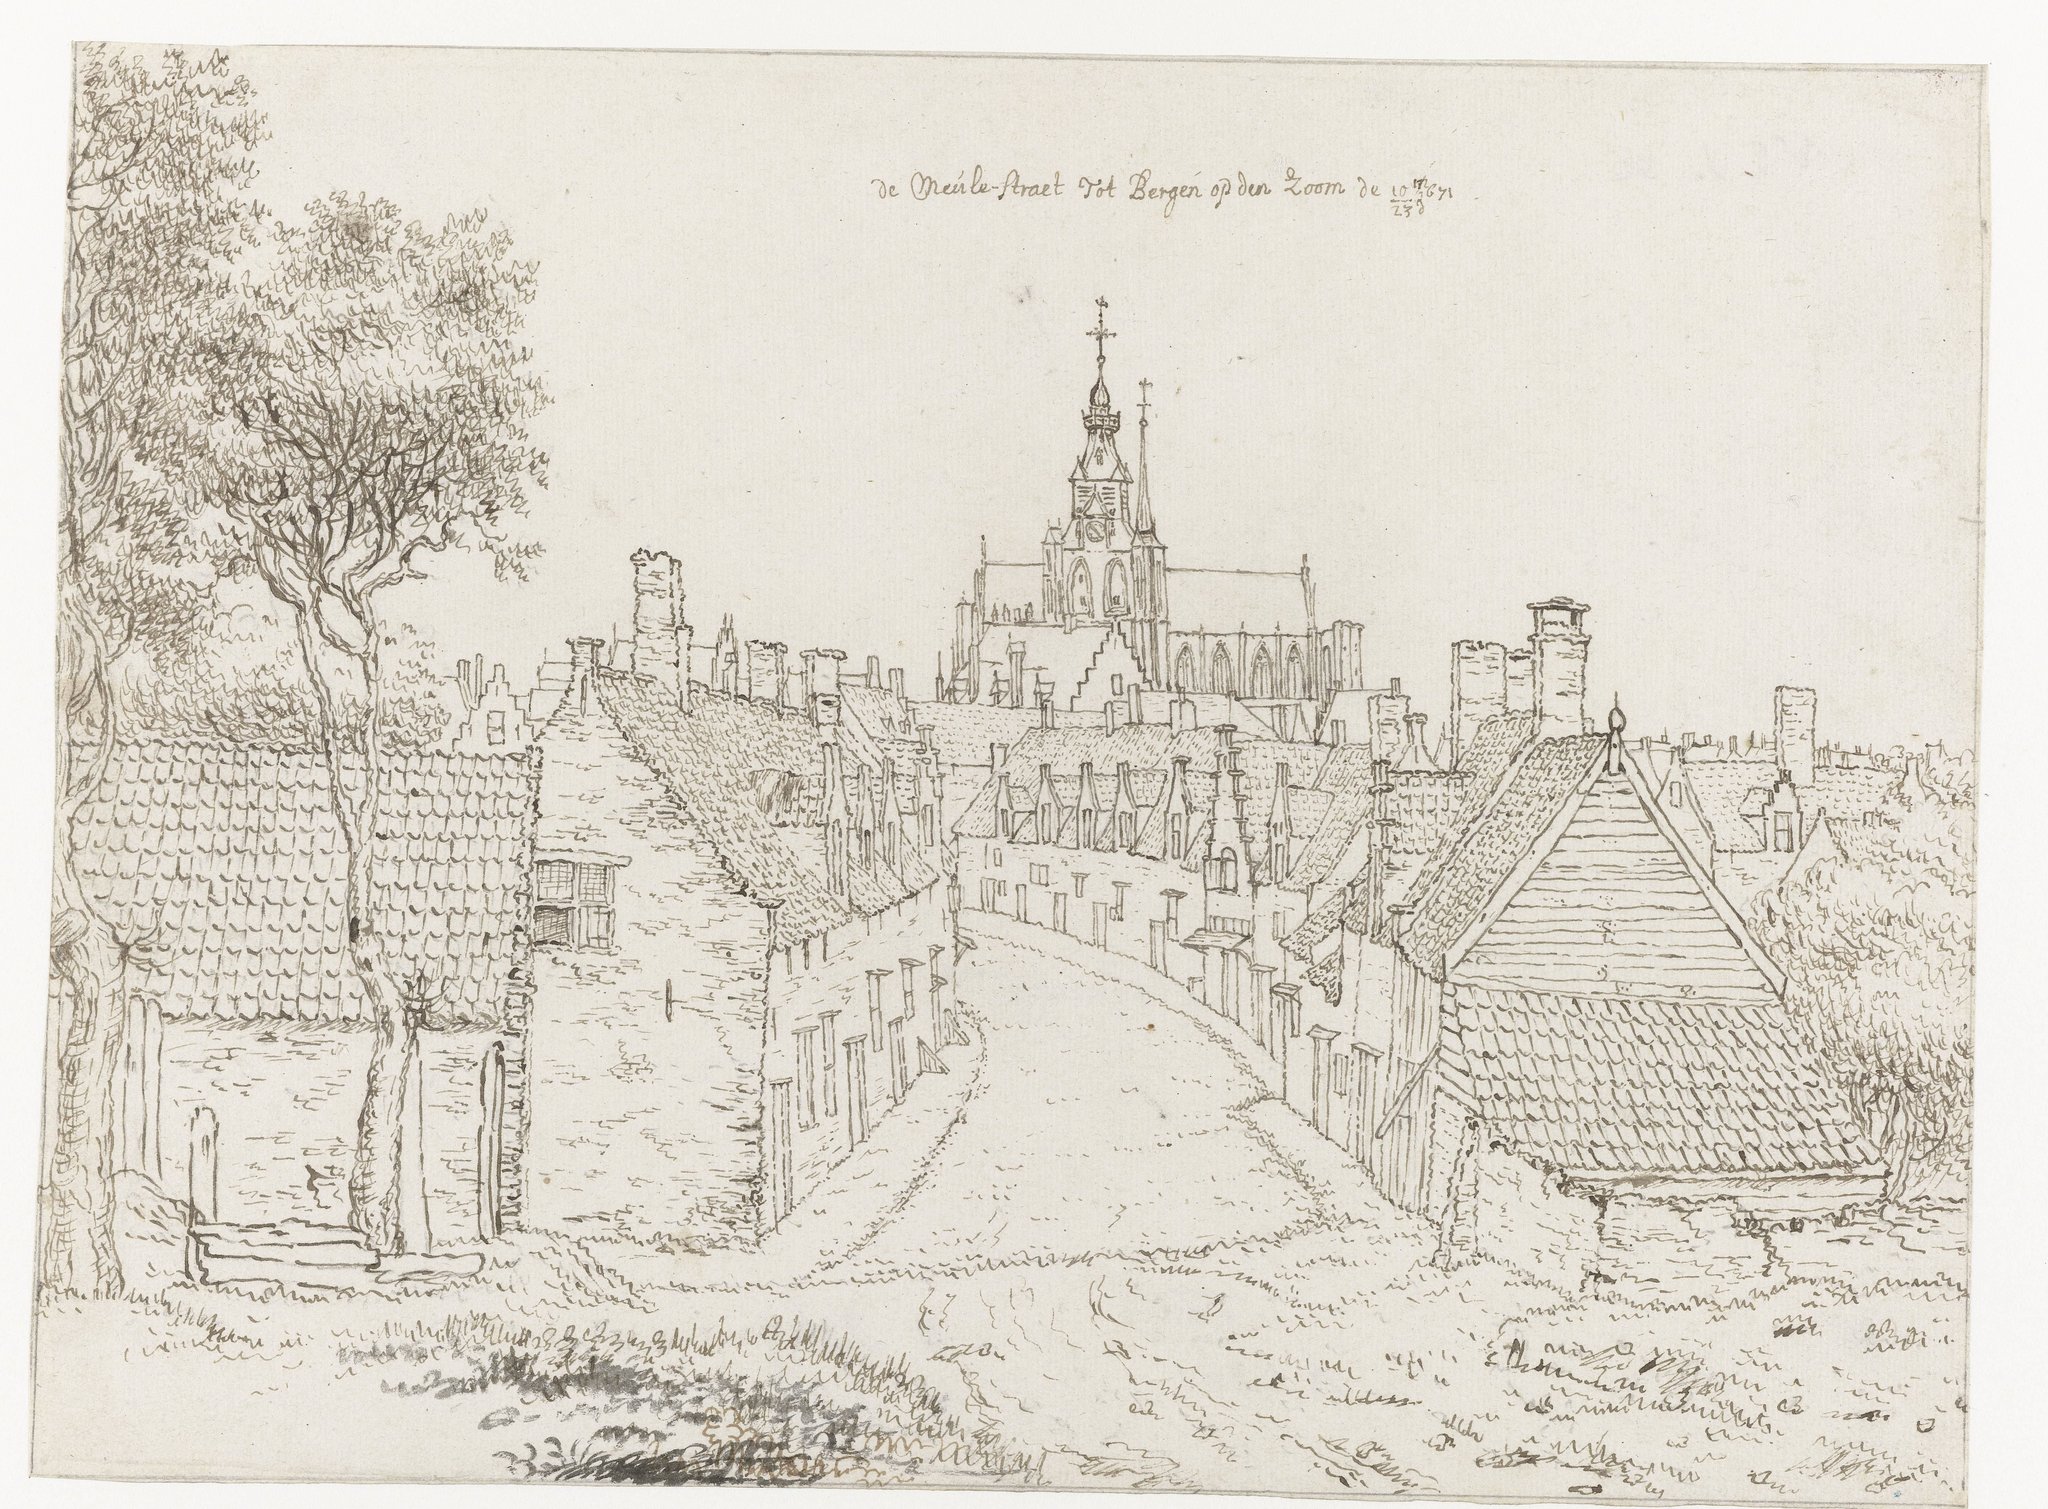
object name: drawing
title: View of the Zuidmolenstraat, Bergen op Zoom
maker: valentijn klotz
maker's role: draughtsman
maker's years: 1646-1721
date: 1671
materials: ink, paper, pencil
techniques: brush, pen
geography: bergen op zoom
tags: street, bergen op zoom